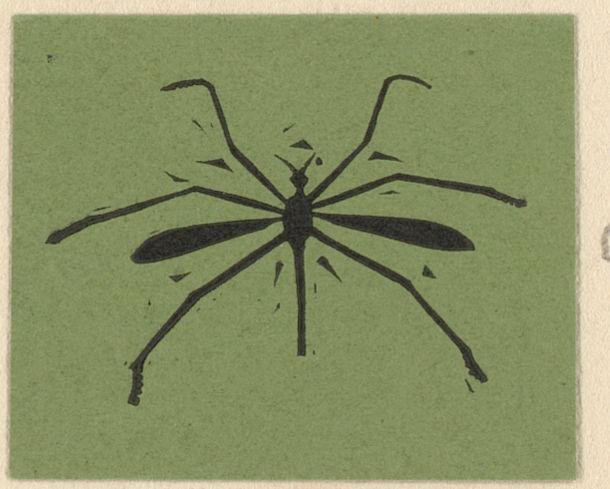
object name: book illustration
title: Sluitvignet met langpootmug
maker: gerrit willem dijsselhof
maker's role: designer, draughtsman, print maker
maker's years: 1866-1924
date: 1893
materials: paper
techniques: galvanoplasty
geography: haarlem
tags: insects: mosquito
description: Sluitvignet gebruikt in: Crane, Walter. Kunst en samenleving. [Vertaald uit het Engels door] Jan Veth. Amsterdam: Scheltema & Holkema's Boekhandel, 1894 [1893], p. 89. Later zijn deze afbeeldingen door de uitgever veelvuldig gebruikt voor andere uitgaven. Zie bijvoorbeeld RP-P-1969-415, een catalogus van de in 1894 bij Scheltema & Holkema's Boekhandel verkrijgbare publicaties.